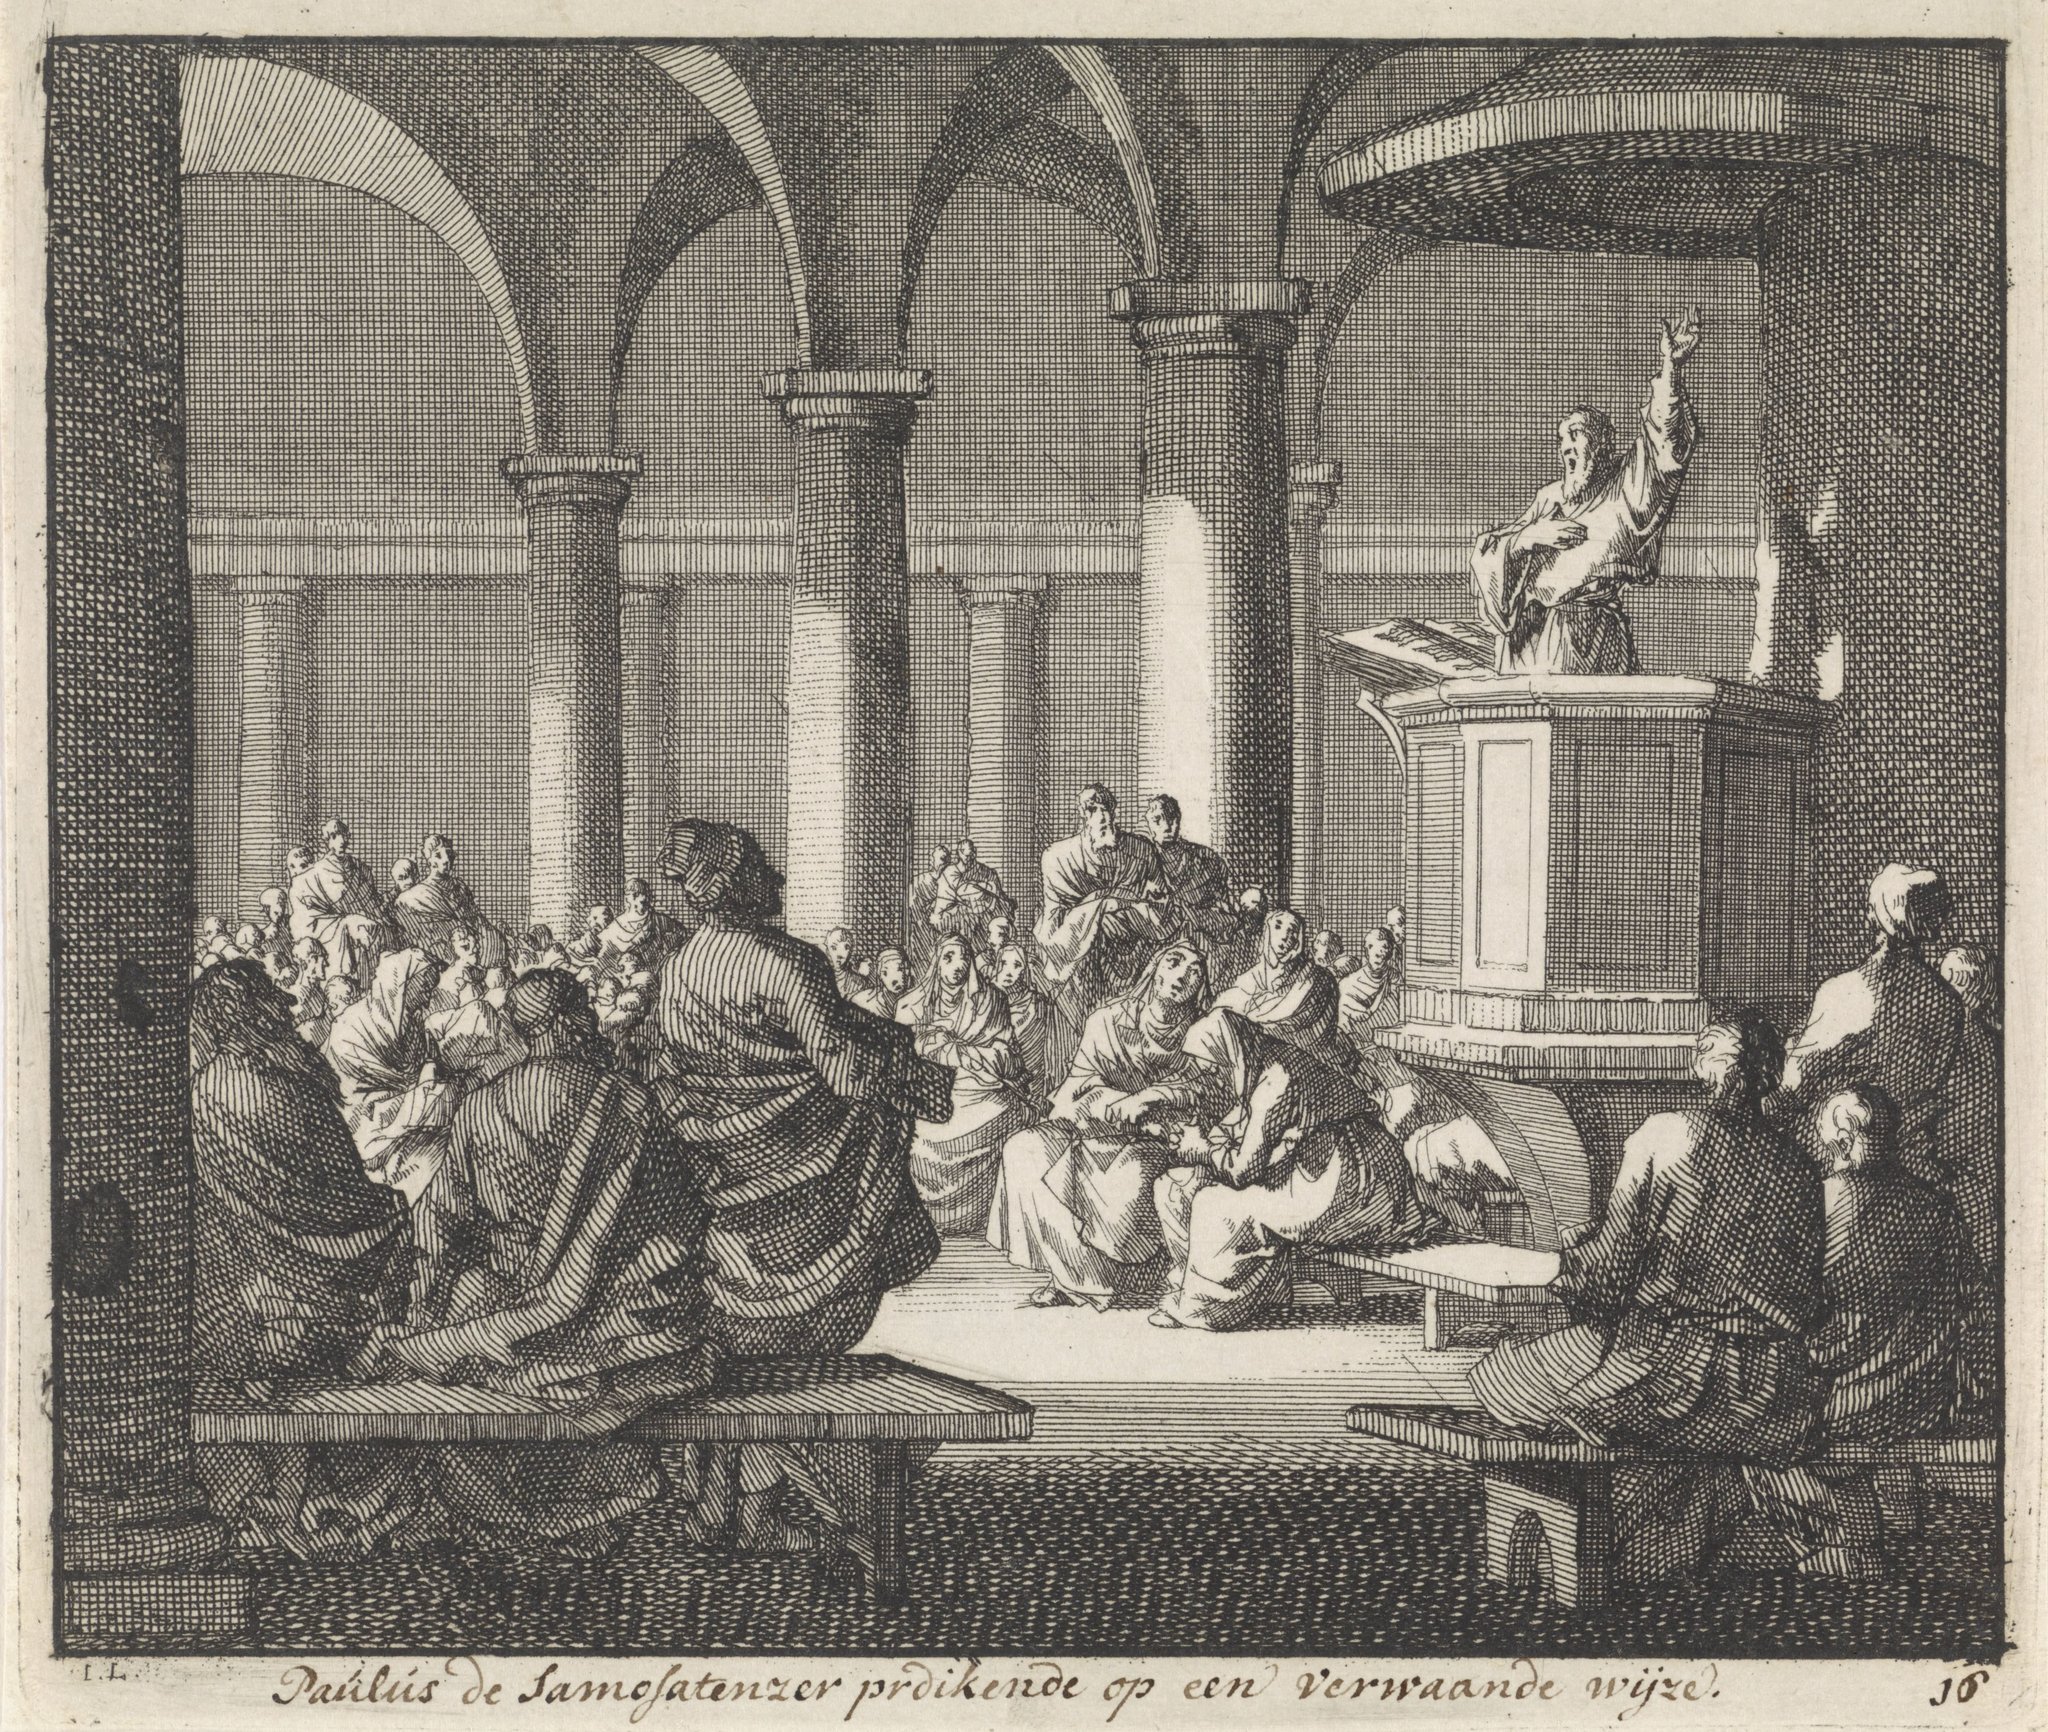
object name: print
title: Paulus van Samosata predikt voor de vroeg-christelijke gemeenschap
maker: jan luyken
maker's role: draughtsman, print maker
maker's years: 1649-1712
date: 1700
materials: paper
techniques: etching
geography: amsterdam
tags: the early christian churches, e.g. armenians, copts, syrians, preaching (in general)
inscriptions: collector's mark: Lugt 2228, caption: ‘Paulus de Samosatenser predikende op een verwaande wijze’, number: ‘16’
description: Proefdruk van een boekillustratie voor Arnold, Godfried. Waare afbeelding der eerste christenen. Amsterdam: Jacobus van Hardenberg, Barent Visscher en Jacobus van Nieuweveen, 1700, dl. 1.